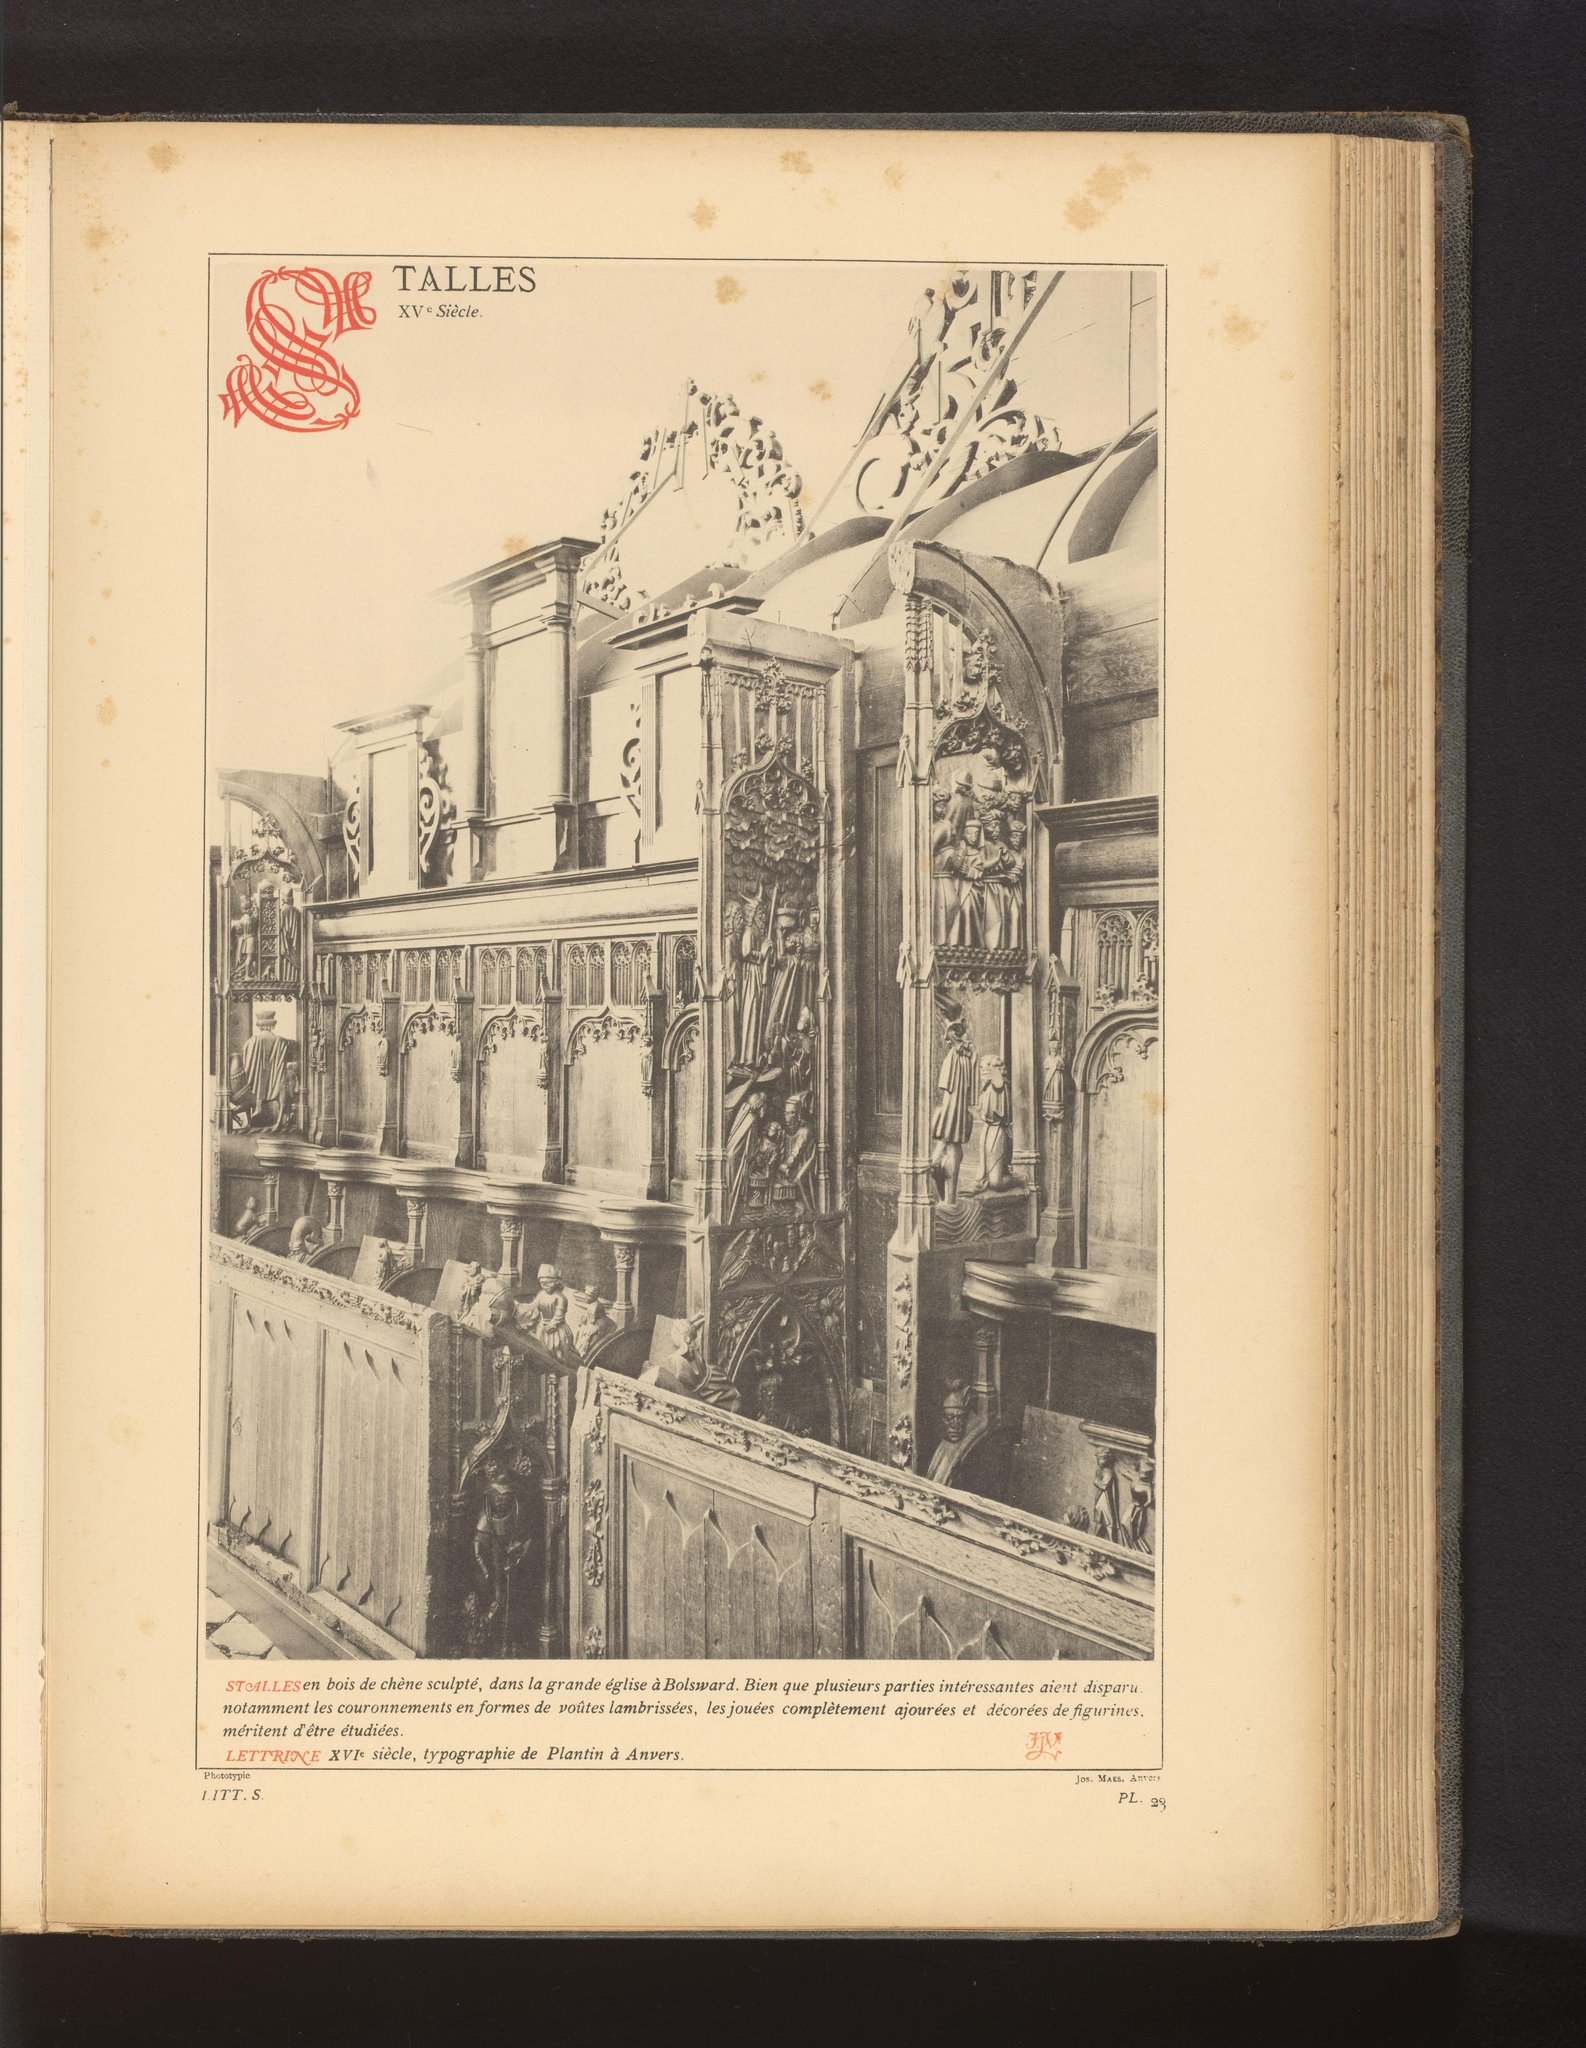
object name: photomechanical print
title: Stalles, XVe Siècle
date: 1876-1881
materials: paper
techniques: photograph, photolithography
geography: antwerp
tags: seats of the clergy, choir-stalls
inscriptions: inscription: ‘STALLES en bois de chène (...)’, inscription: ‘LITT. S. - PL. 23.’, monogram: ‘JJvY’